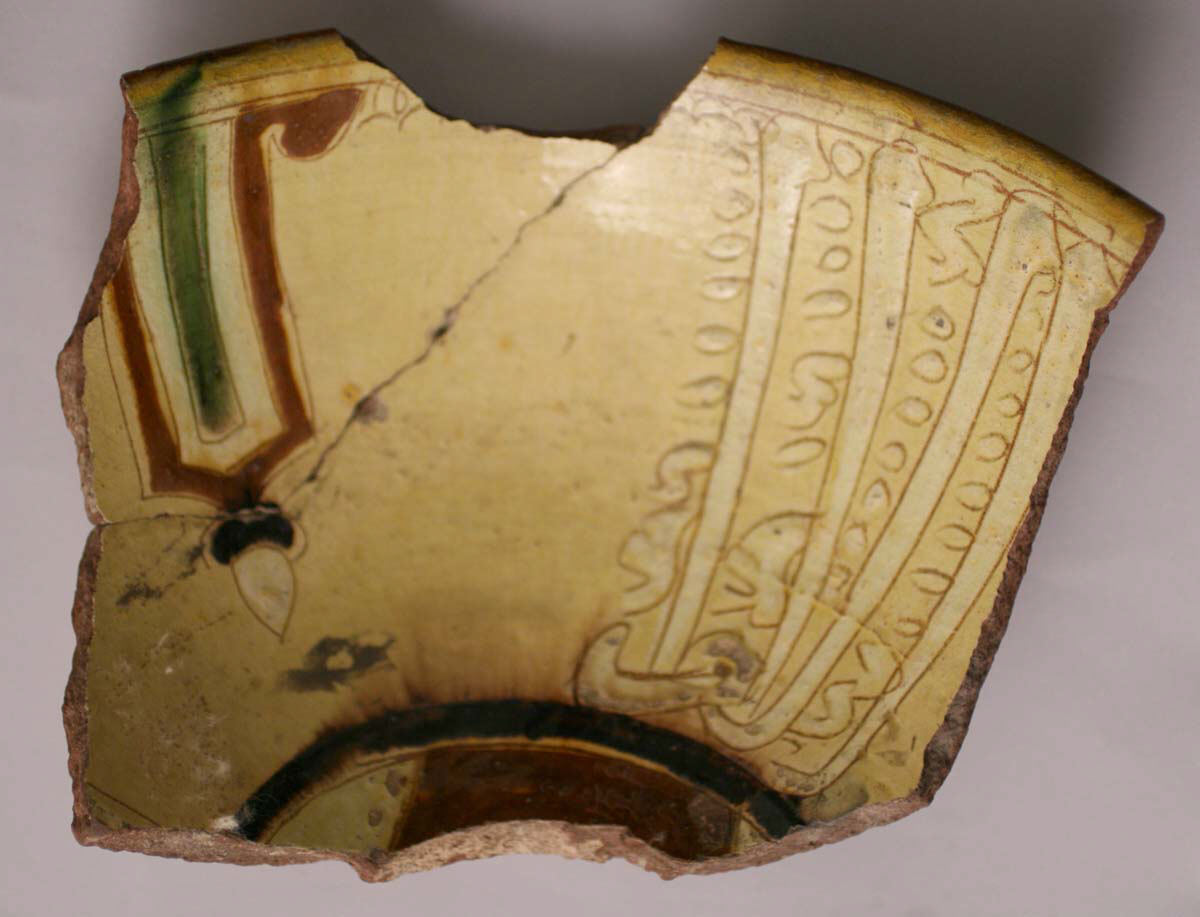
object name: fragment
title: Fragment of a Bowl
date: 1301-1500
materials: earthenware, glaze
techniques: coloring, incising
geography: egypt